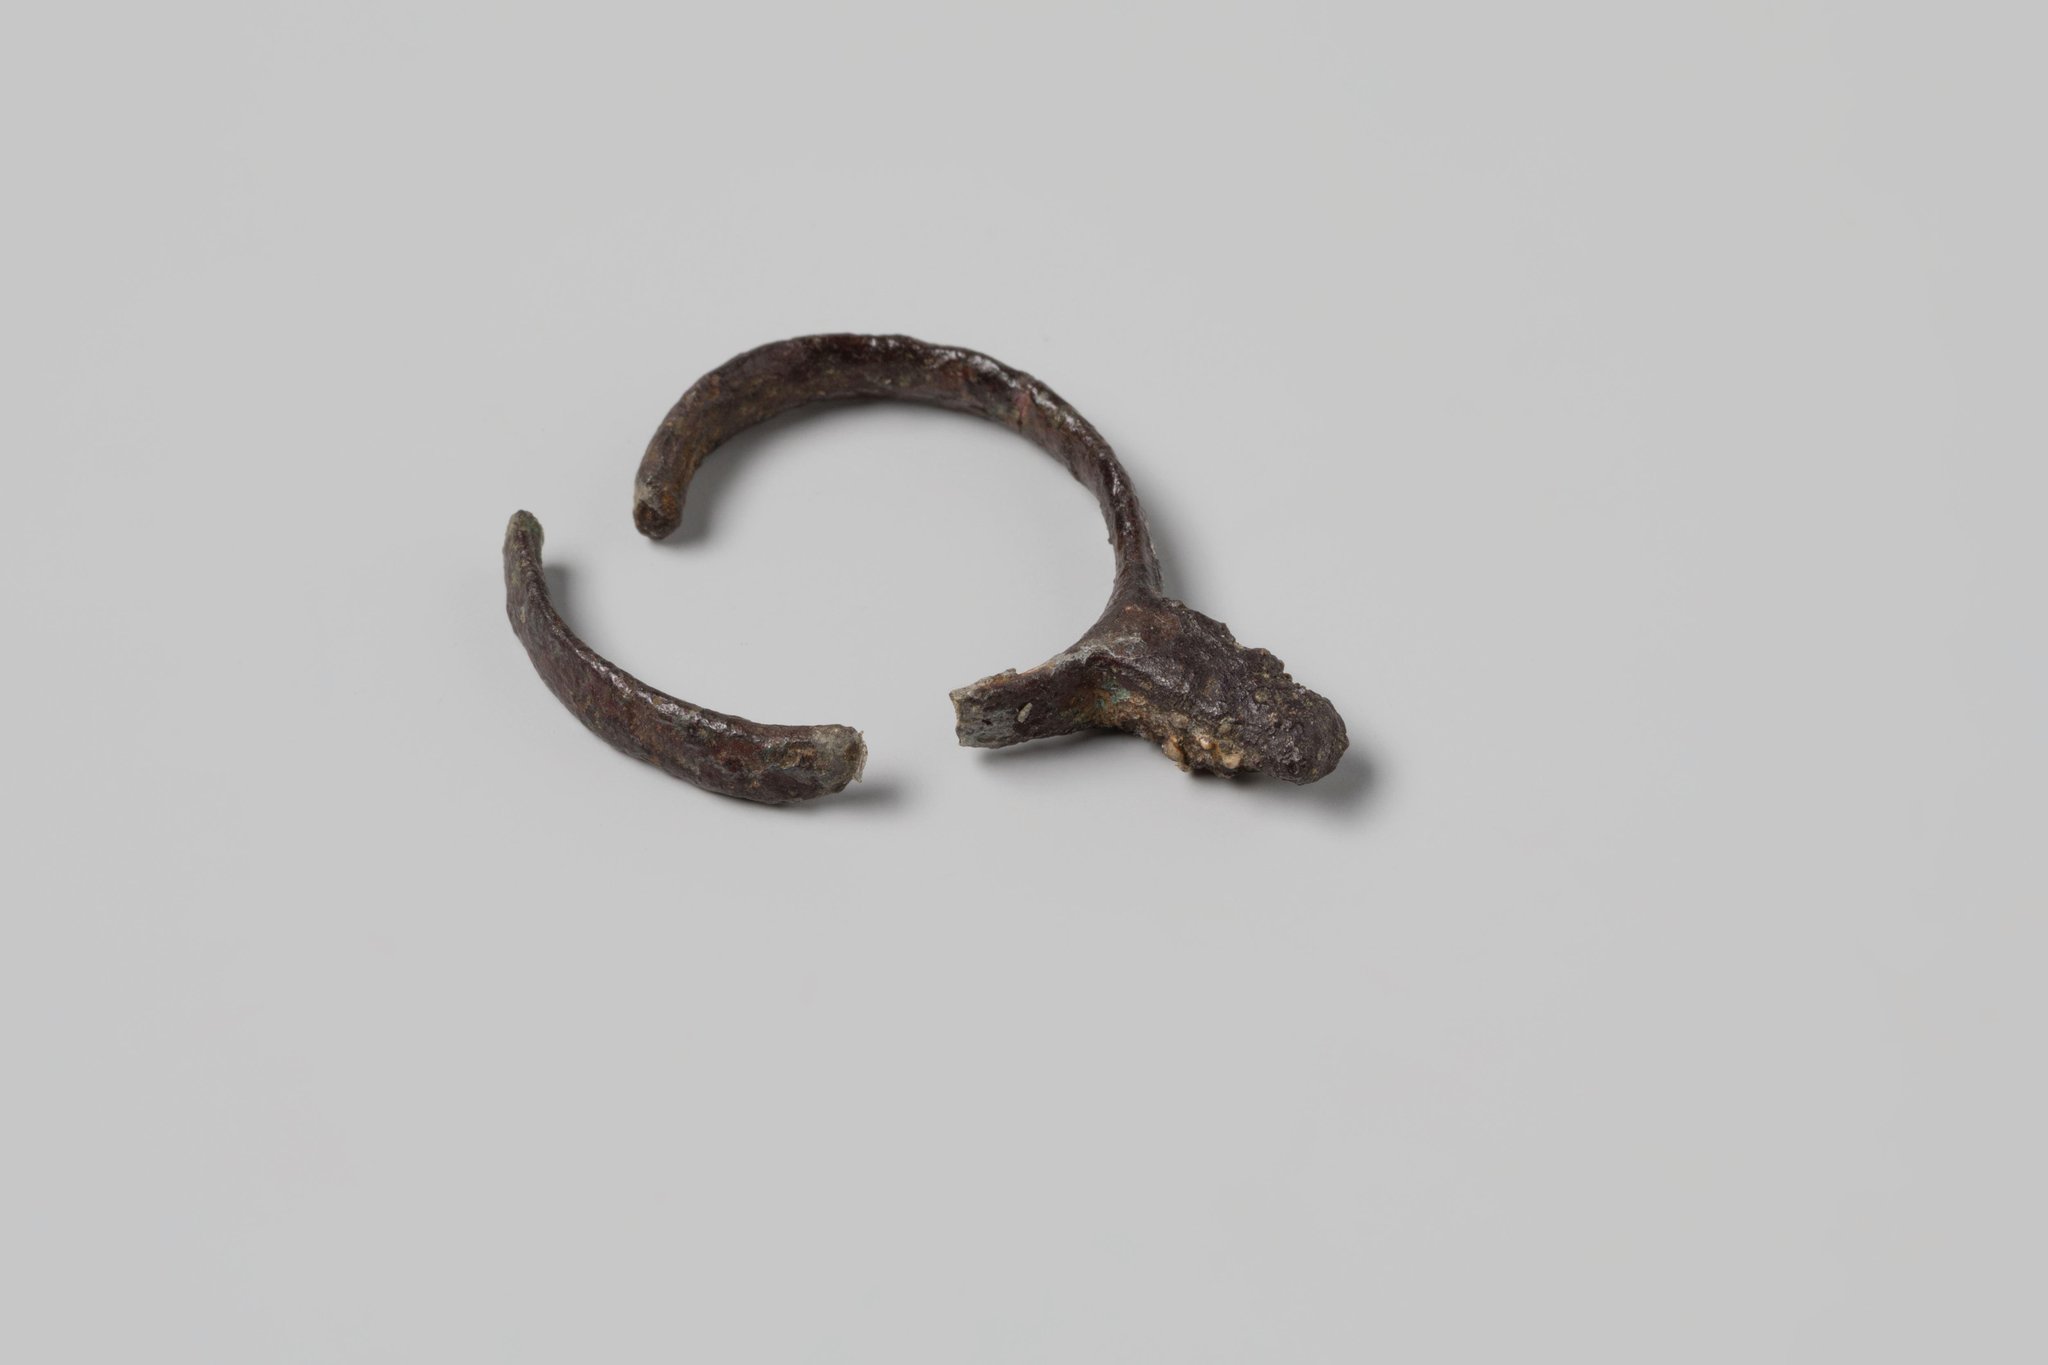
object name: pin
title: Gebroken speld uit het wrak van de Oost-Indiëvaarder Hollandia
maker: Anonymous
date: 1700-1743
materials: copper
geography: netherlands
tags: verenigde oostindische compagnie, hollandia (schip), annet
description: Tools and instruments, sewing and sailmaking, pin; fragm, bow, id. NG 1980-27H3265.